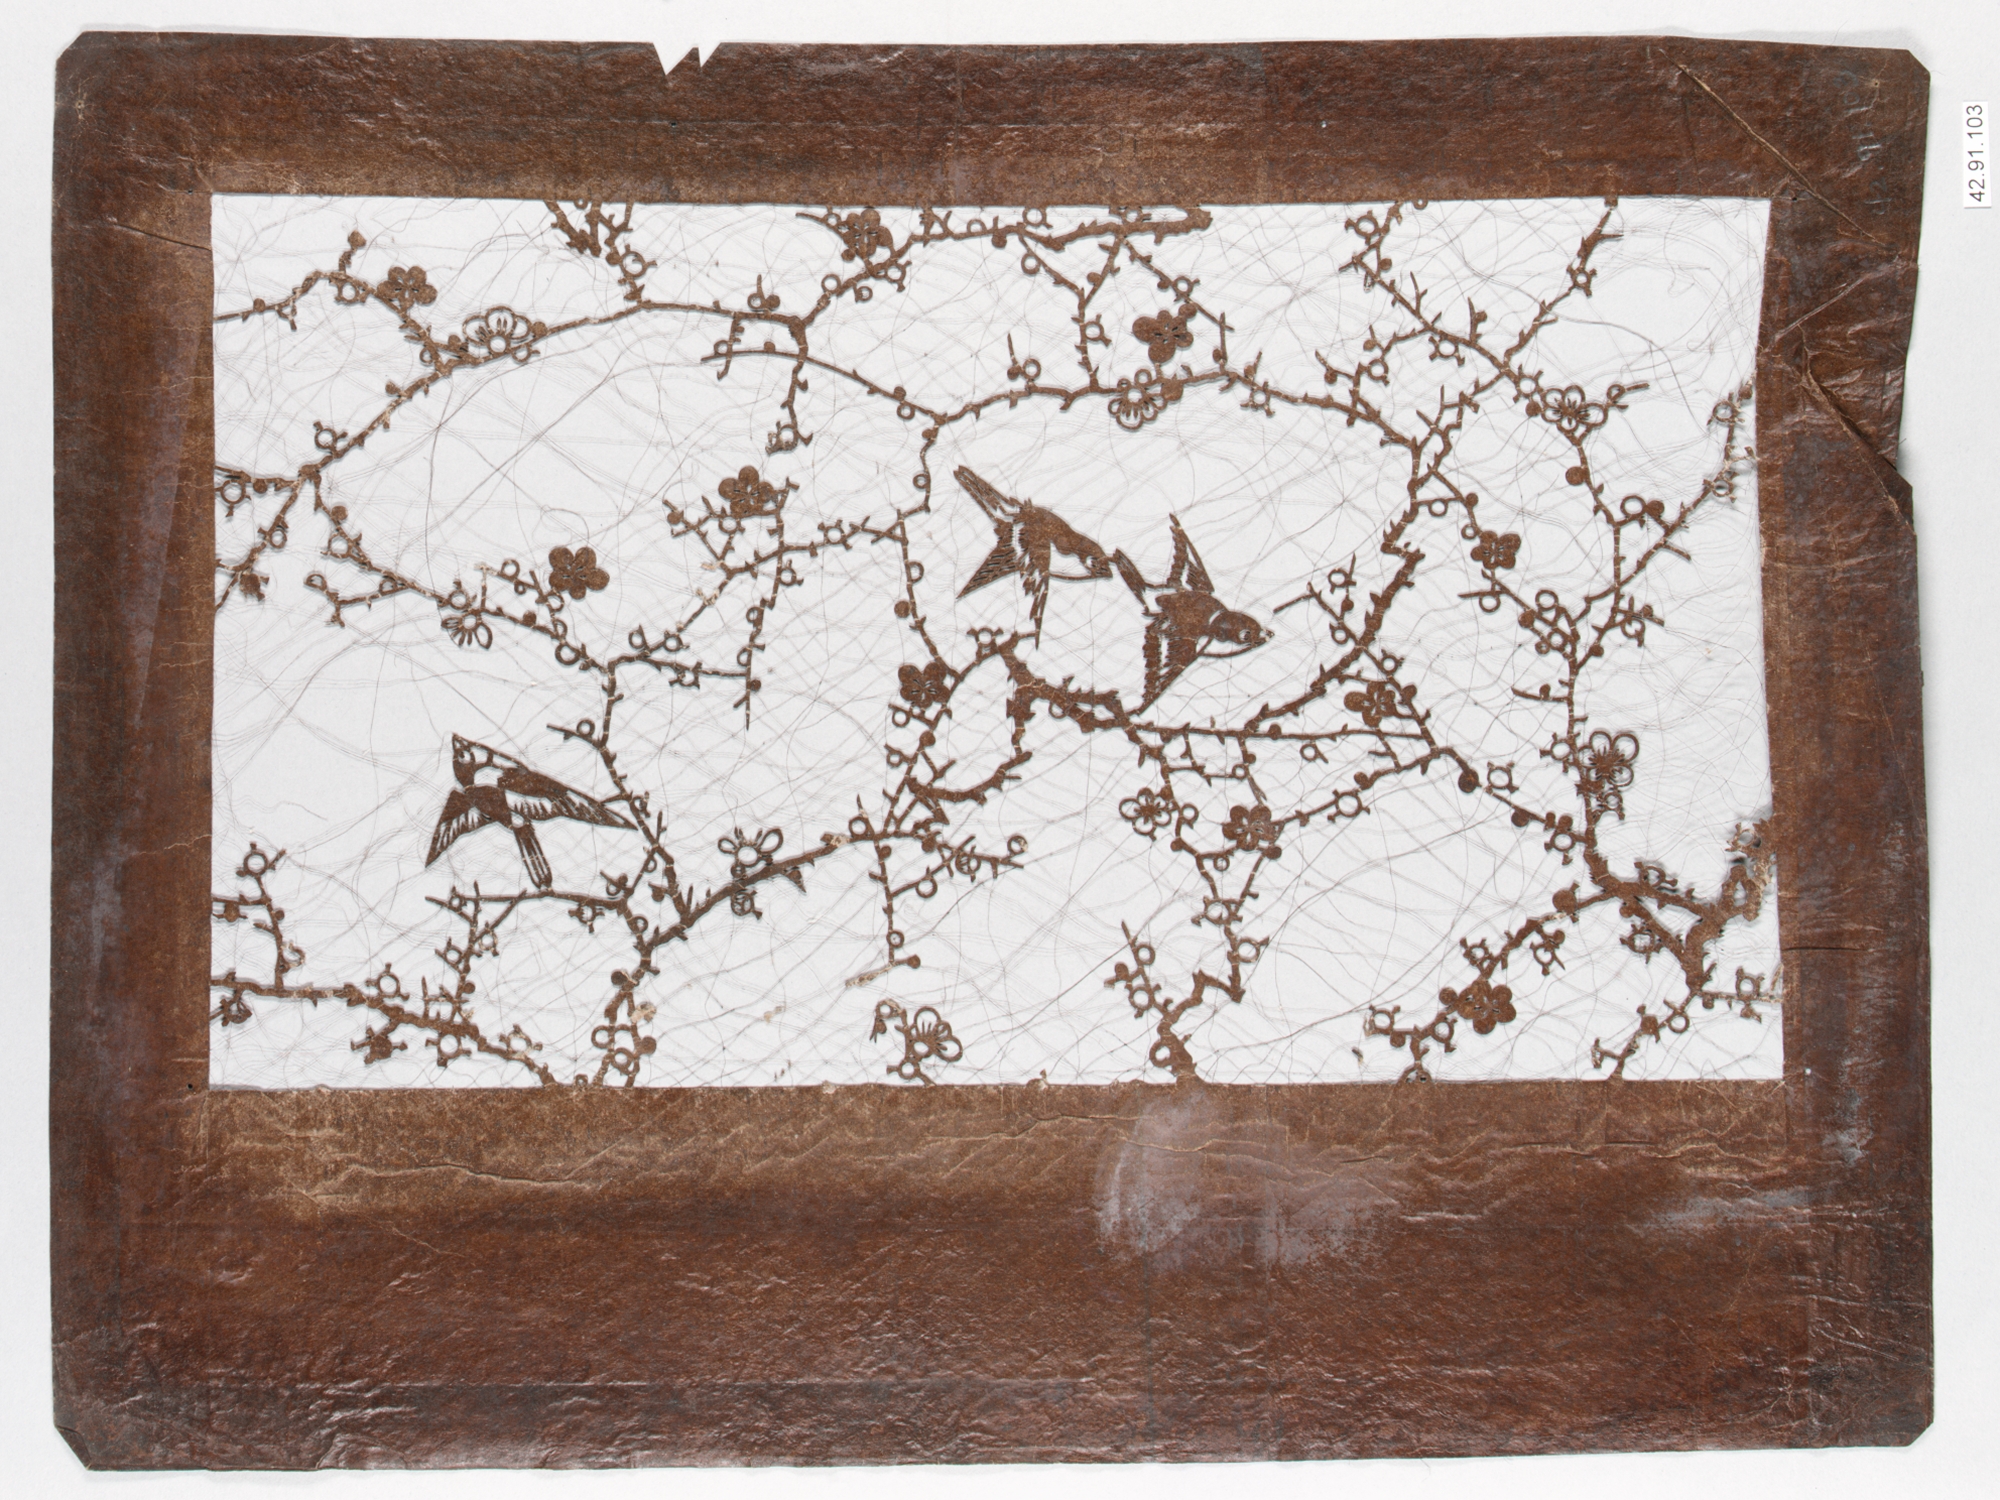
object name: stencil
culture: japanese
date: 1801-1900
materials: paper, silk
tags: birds